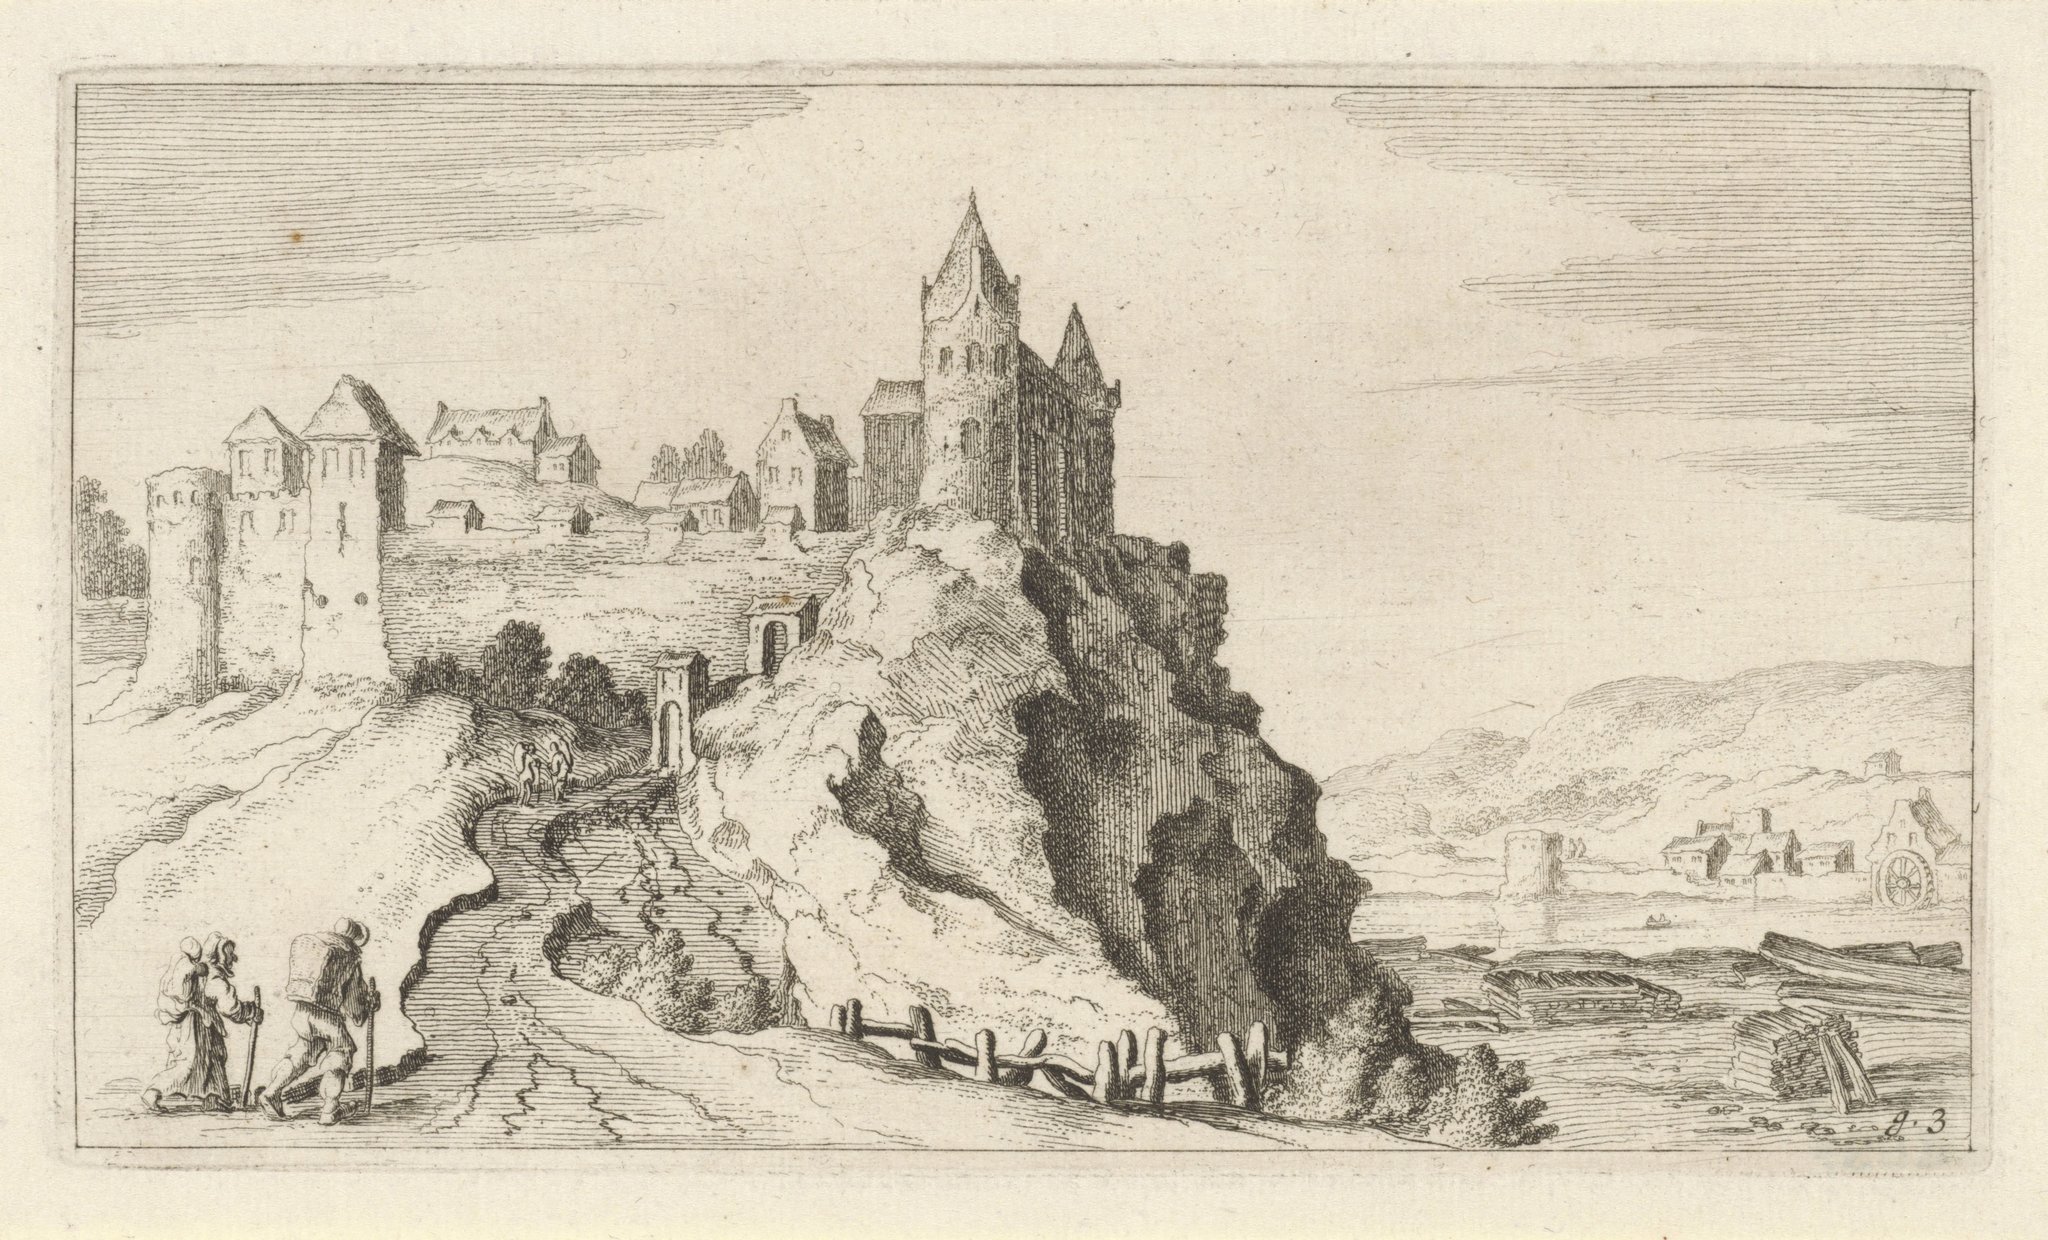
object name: print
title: Vestingstad op een heuvel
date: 1640-1706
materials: paper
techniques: etching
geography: amsterdam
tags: river, fortified city, watermill in landscape, 'en route', traveller under way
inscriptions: collector's mark: Lugt 2165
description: Op een heuvel boven een rivier ligt een vestingstad. Op de voorgrond wandelen een vrouw met een kind op de rug en een man. De prent maakt deel uit van een serie van twaalf landschappen.